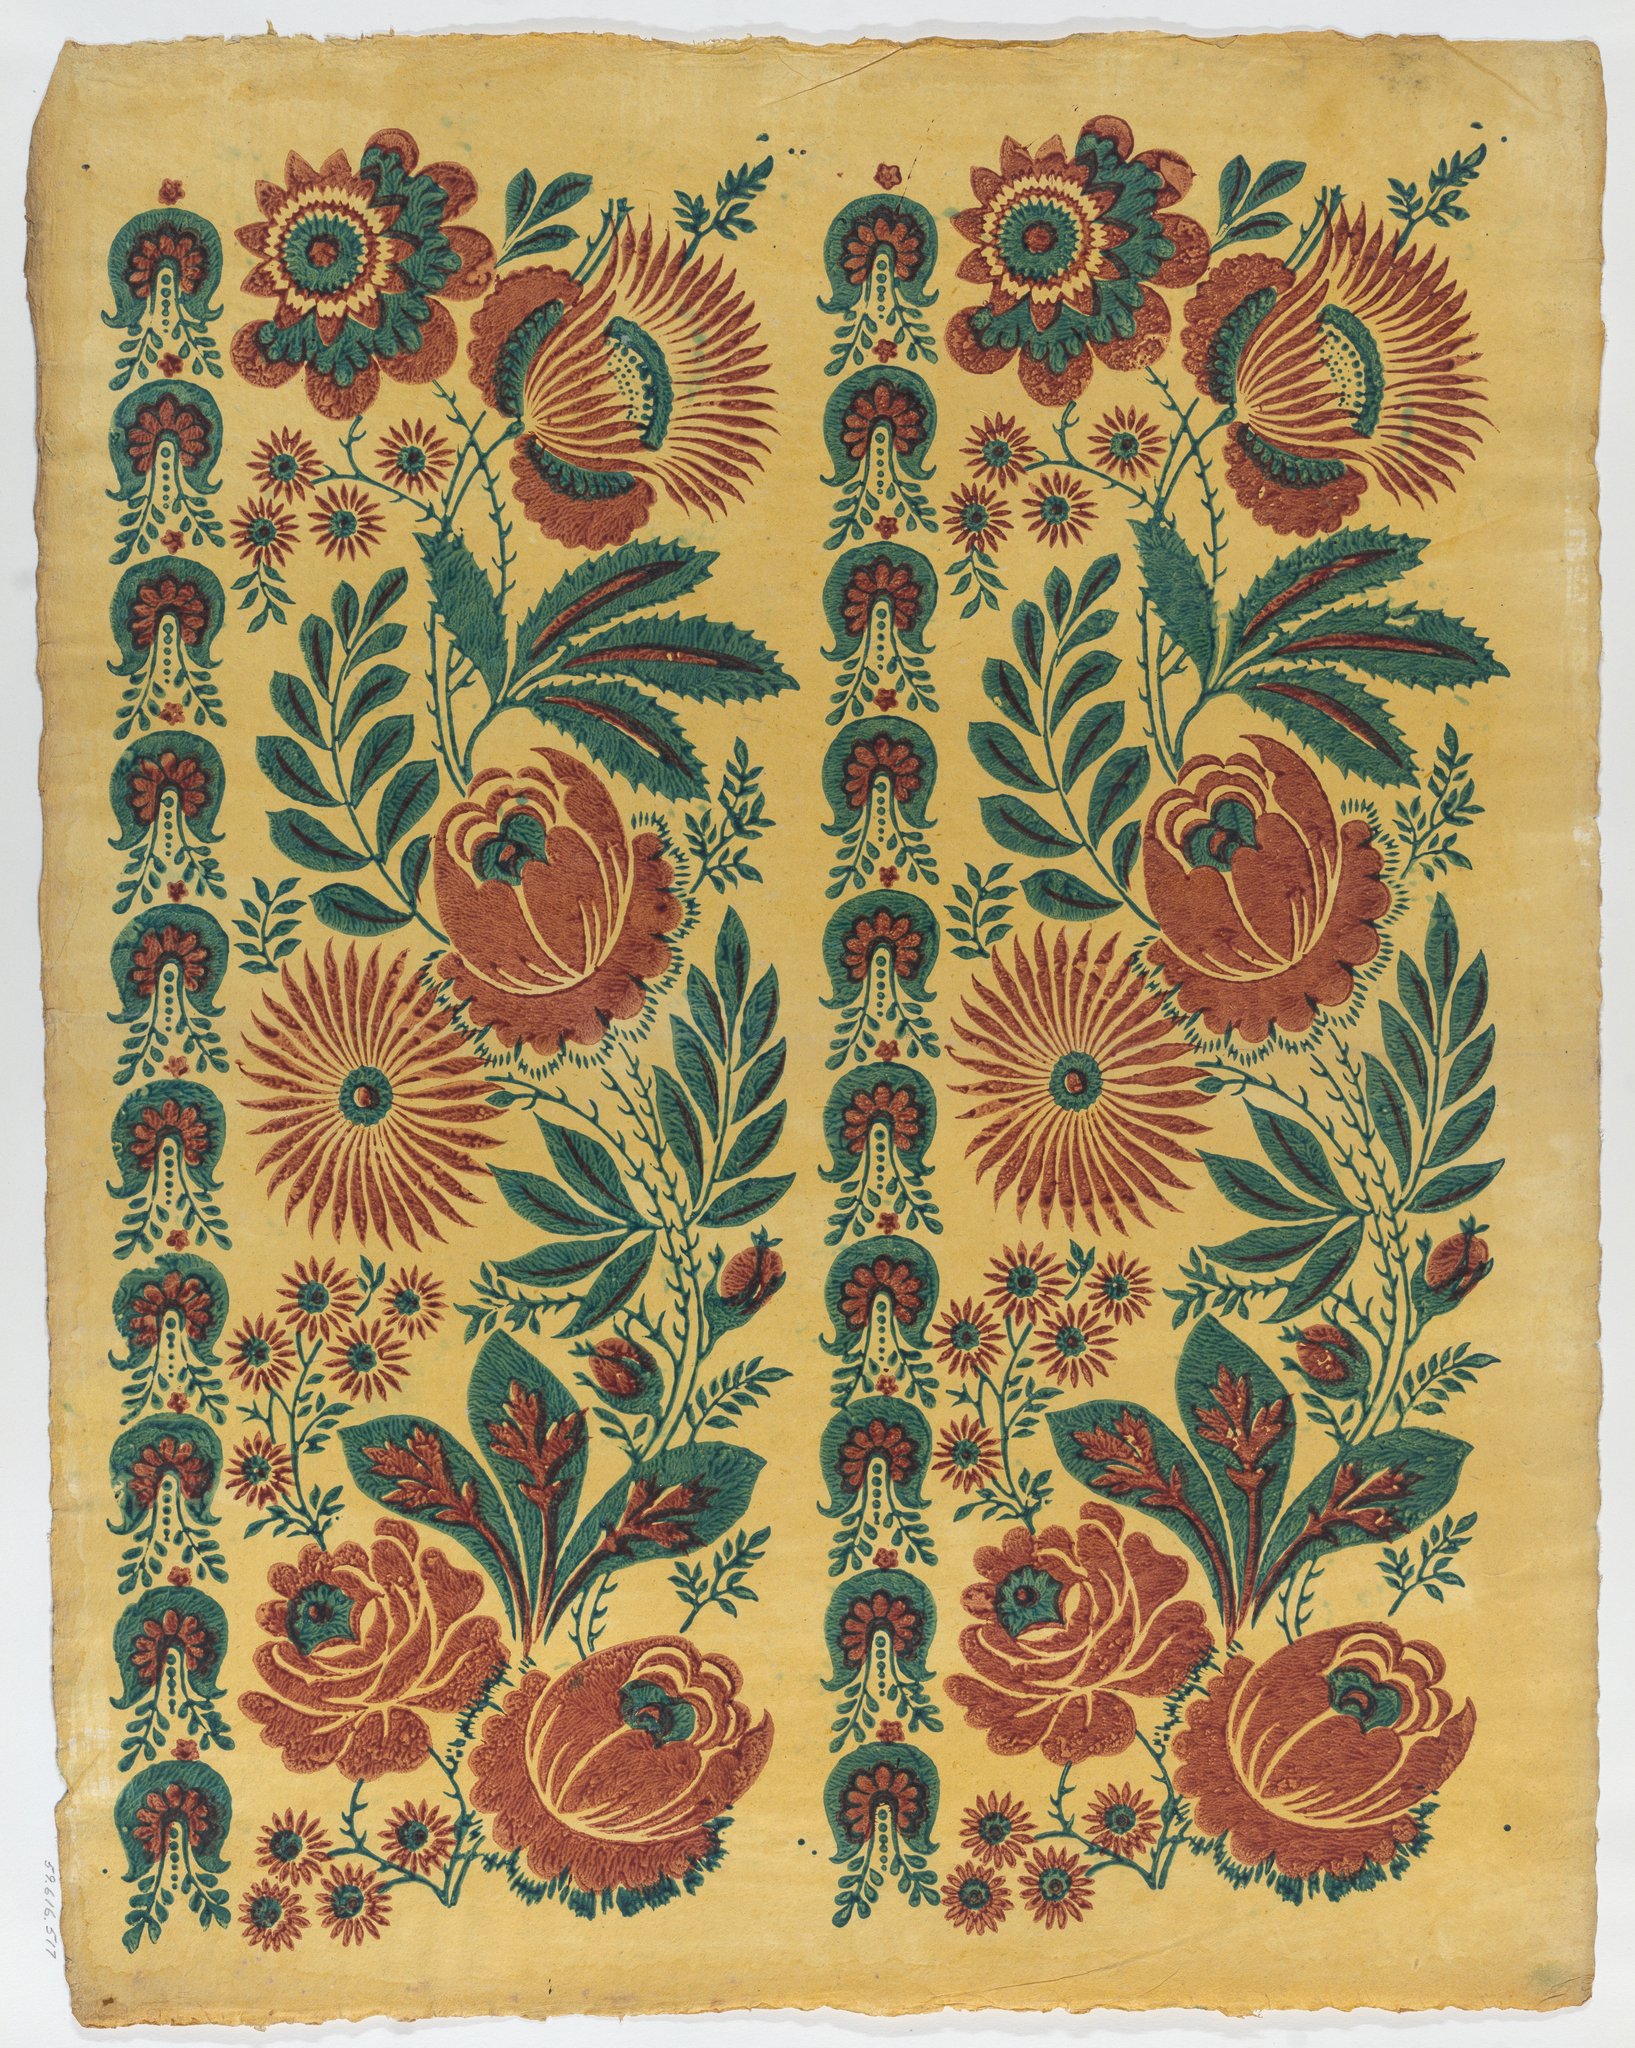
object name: print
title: Sheet with two floral borders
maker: Anonymous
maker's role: artist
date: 1701-1800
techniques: relief print